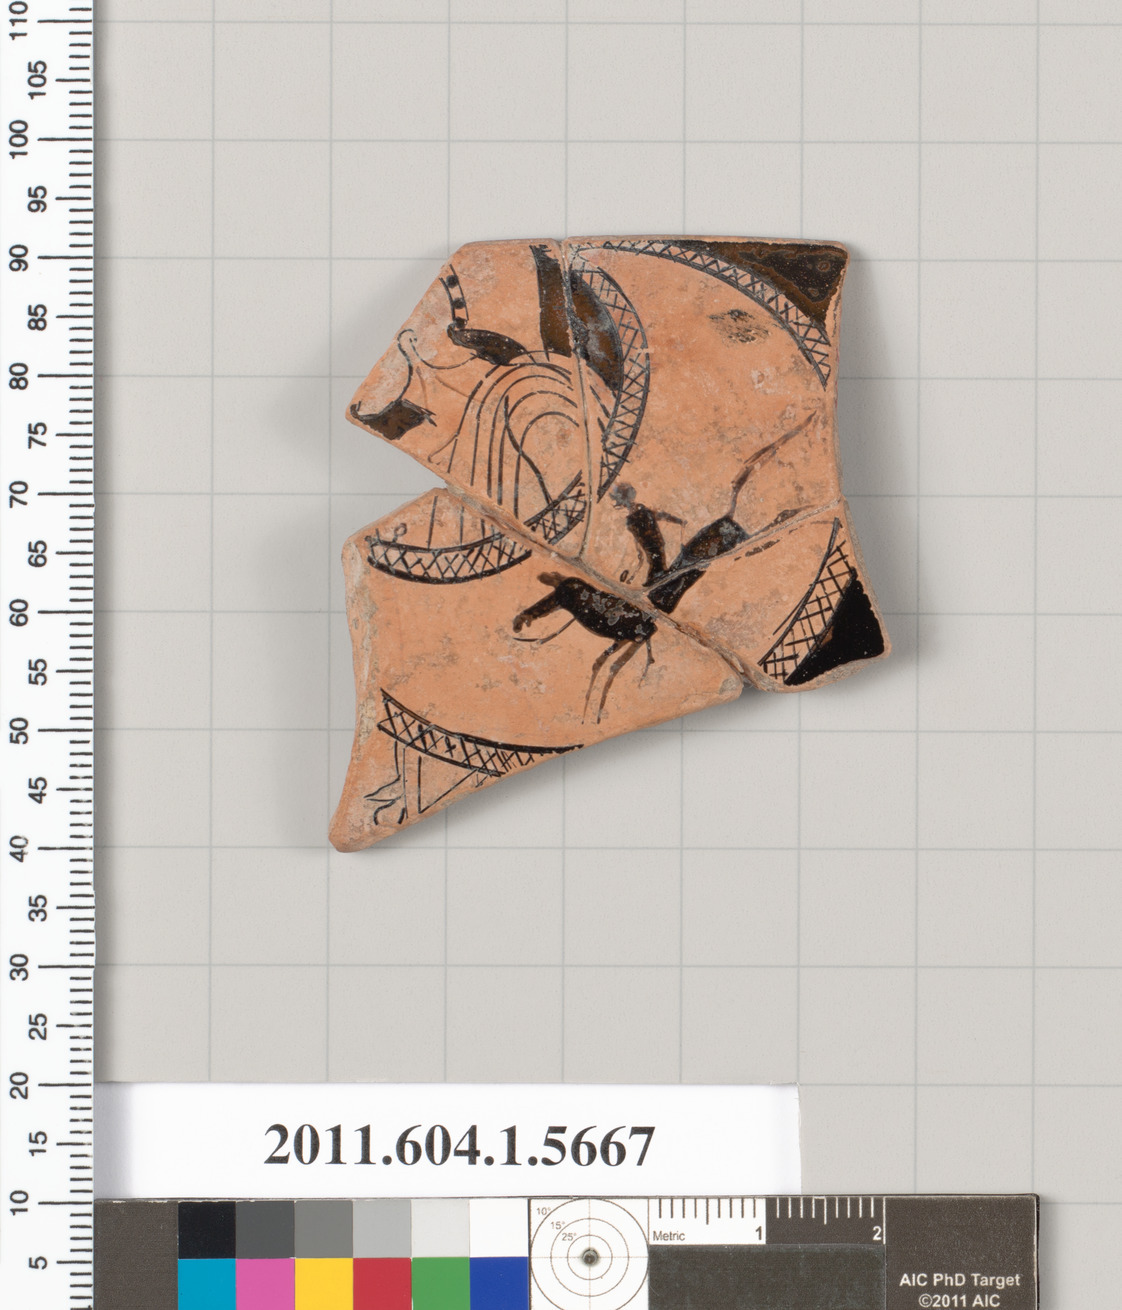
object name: kylix fragment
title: Terracotta rim fragment of a kylix (drinking cup)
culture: greek, attic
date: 520-510 BCE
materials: terracotta